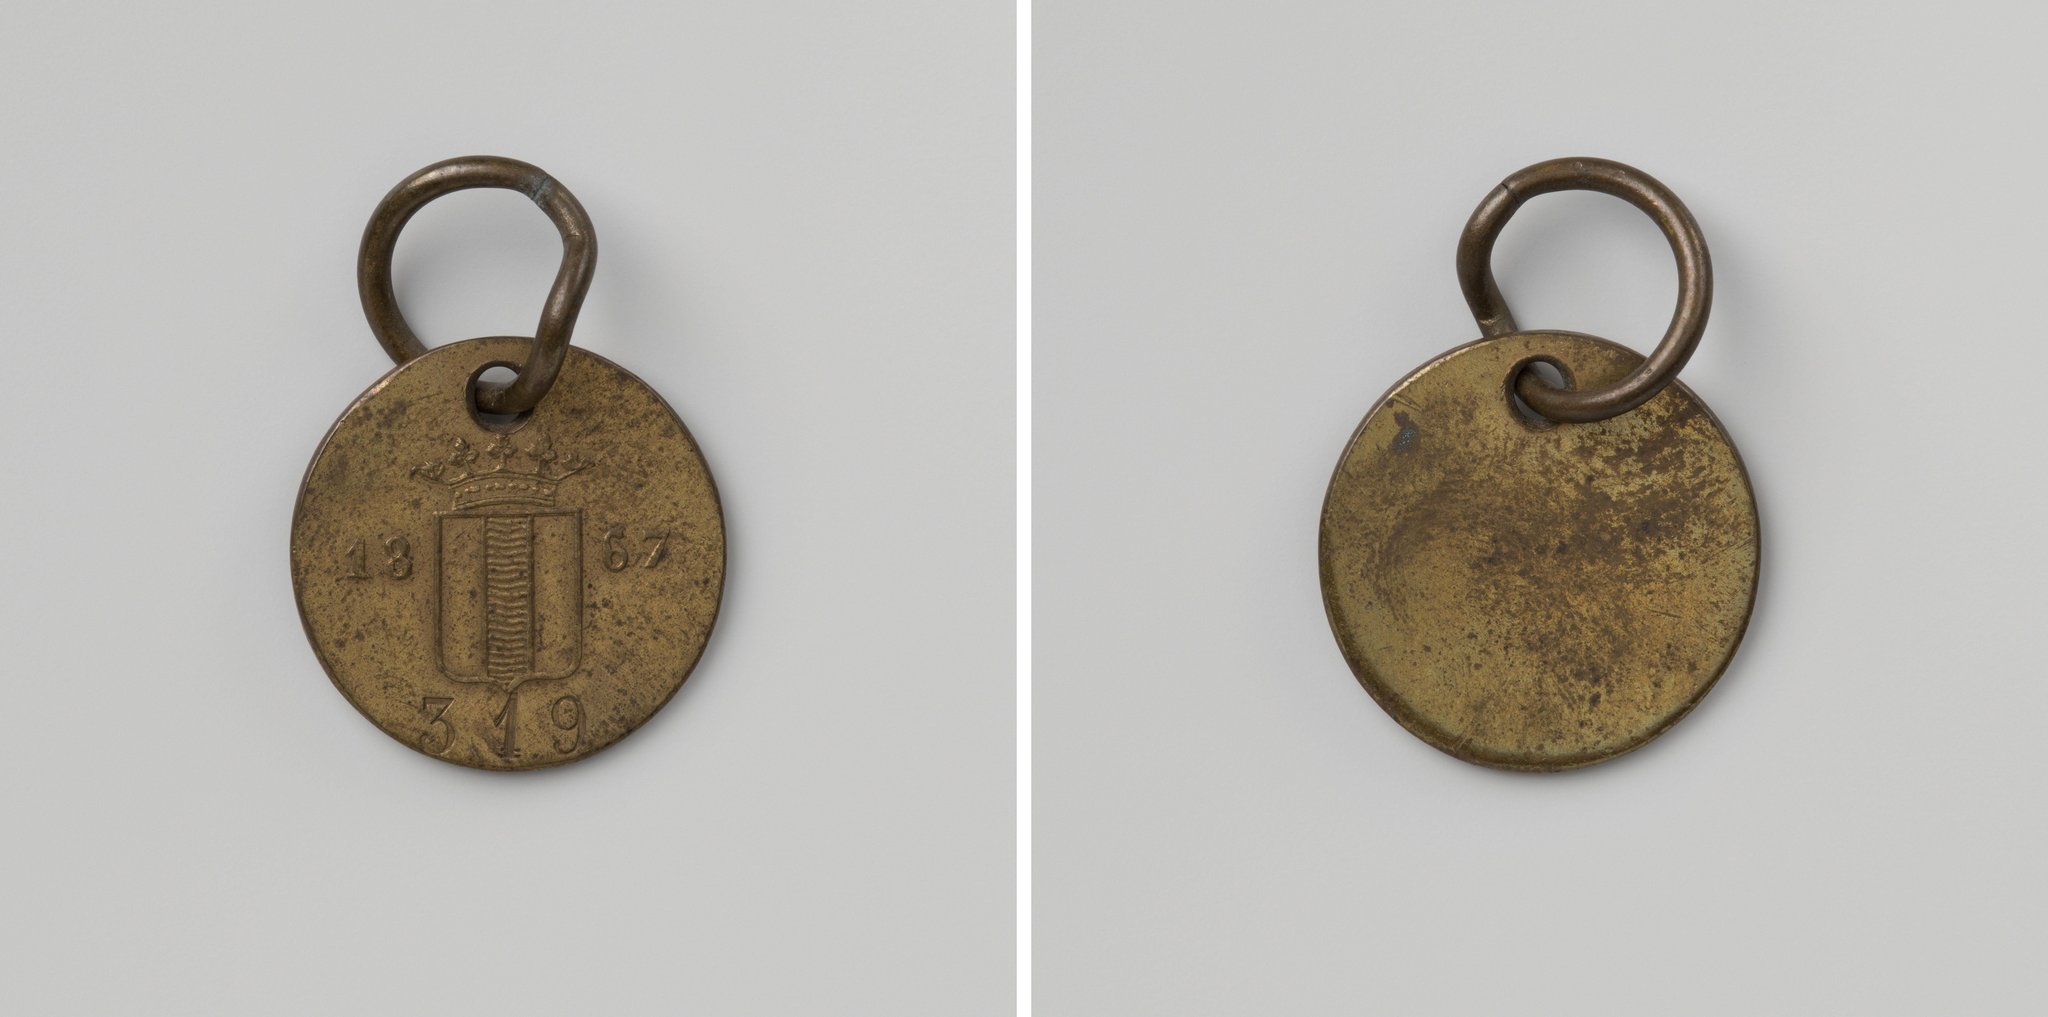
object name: tax token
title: Stad Delft, loodje met no. 319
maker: Anonymous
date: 1867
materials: brass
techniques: striking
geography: delft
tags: delft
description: eenzijdig loodje met gat erin aan draagring. Voorzijde: gekroond wapenschild tussen jaartal boven cijfer 319. Keerzijde: blanco